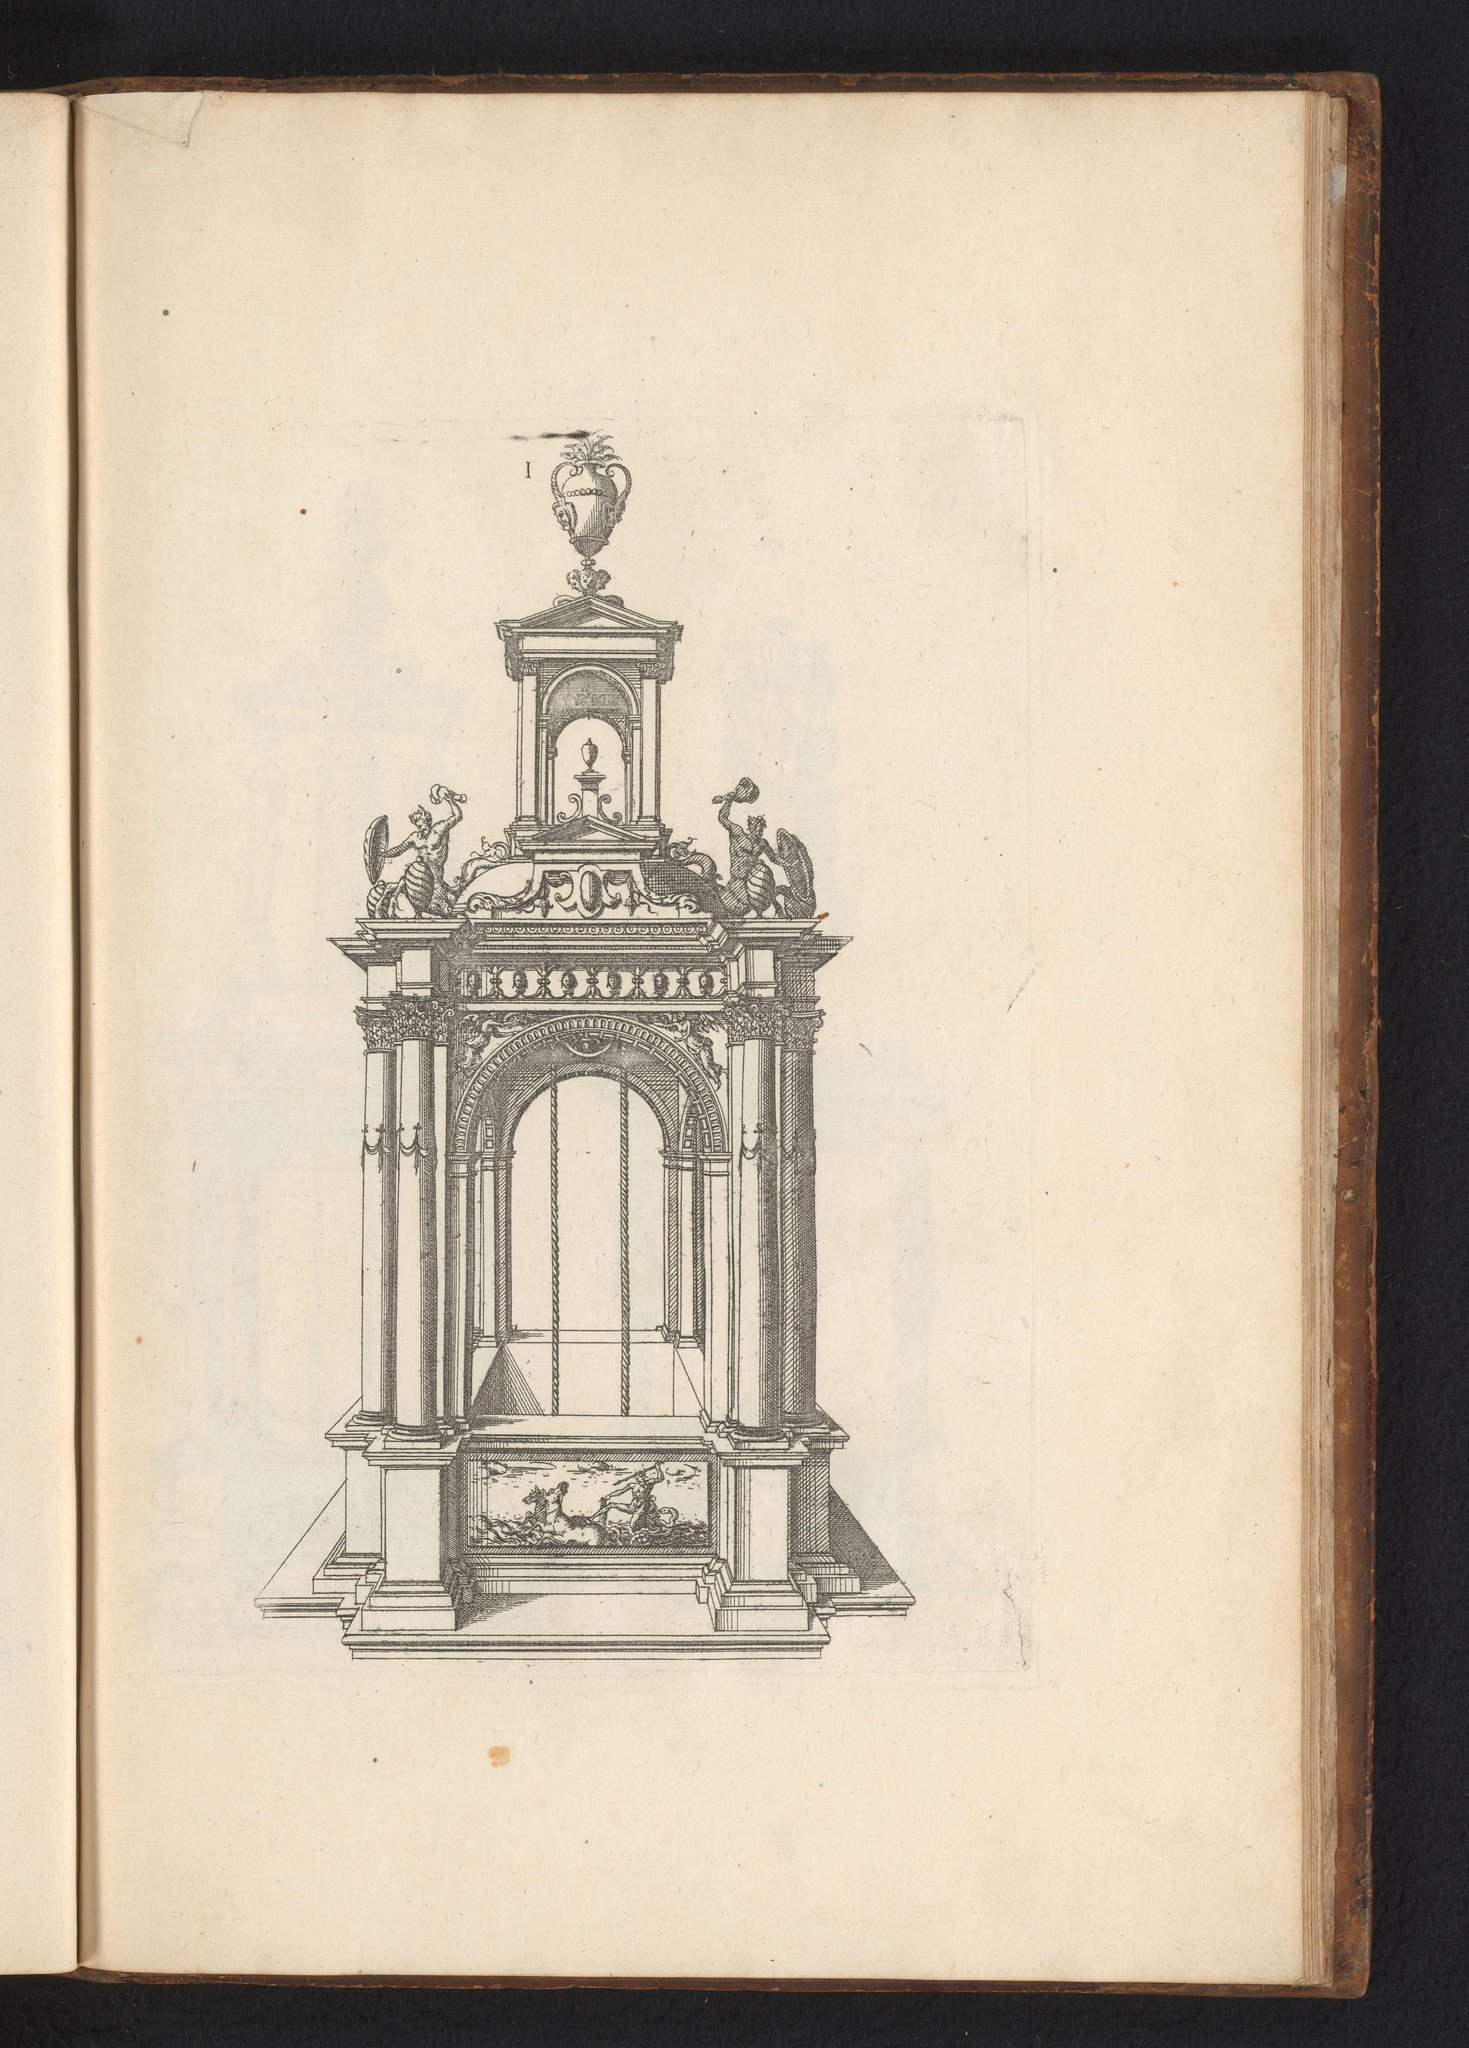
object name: ornament print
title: Waterput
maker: jacques androuet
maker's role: draughtsman, print maker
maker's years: 1515-1584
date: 1561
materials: paper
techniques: etching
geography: paris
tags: well, architectural design or model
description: Waterput. Onderdeel van 'Seconde livre d'architectvre' (1561): 64 etsen met geornamenteerde architectuuronderdelen.